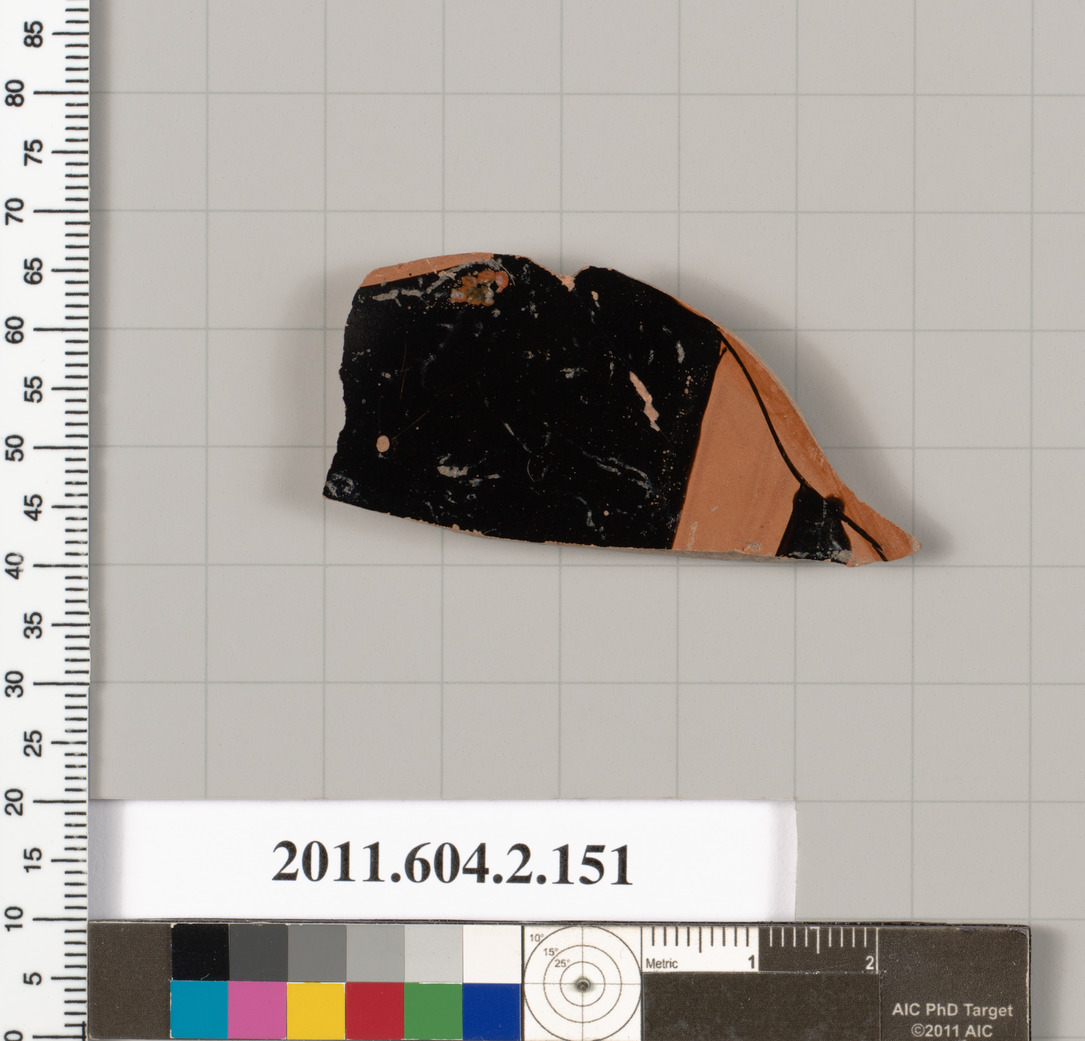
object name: stamnos fragment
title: Terracotta fragment of a stamnos (jar)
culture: greek, attic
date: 480-460 BCE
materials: terracotta